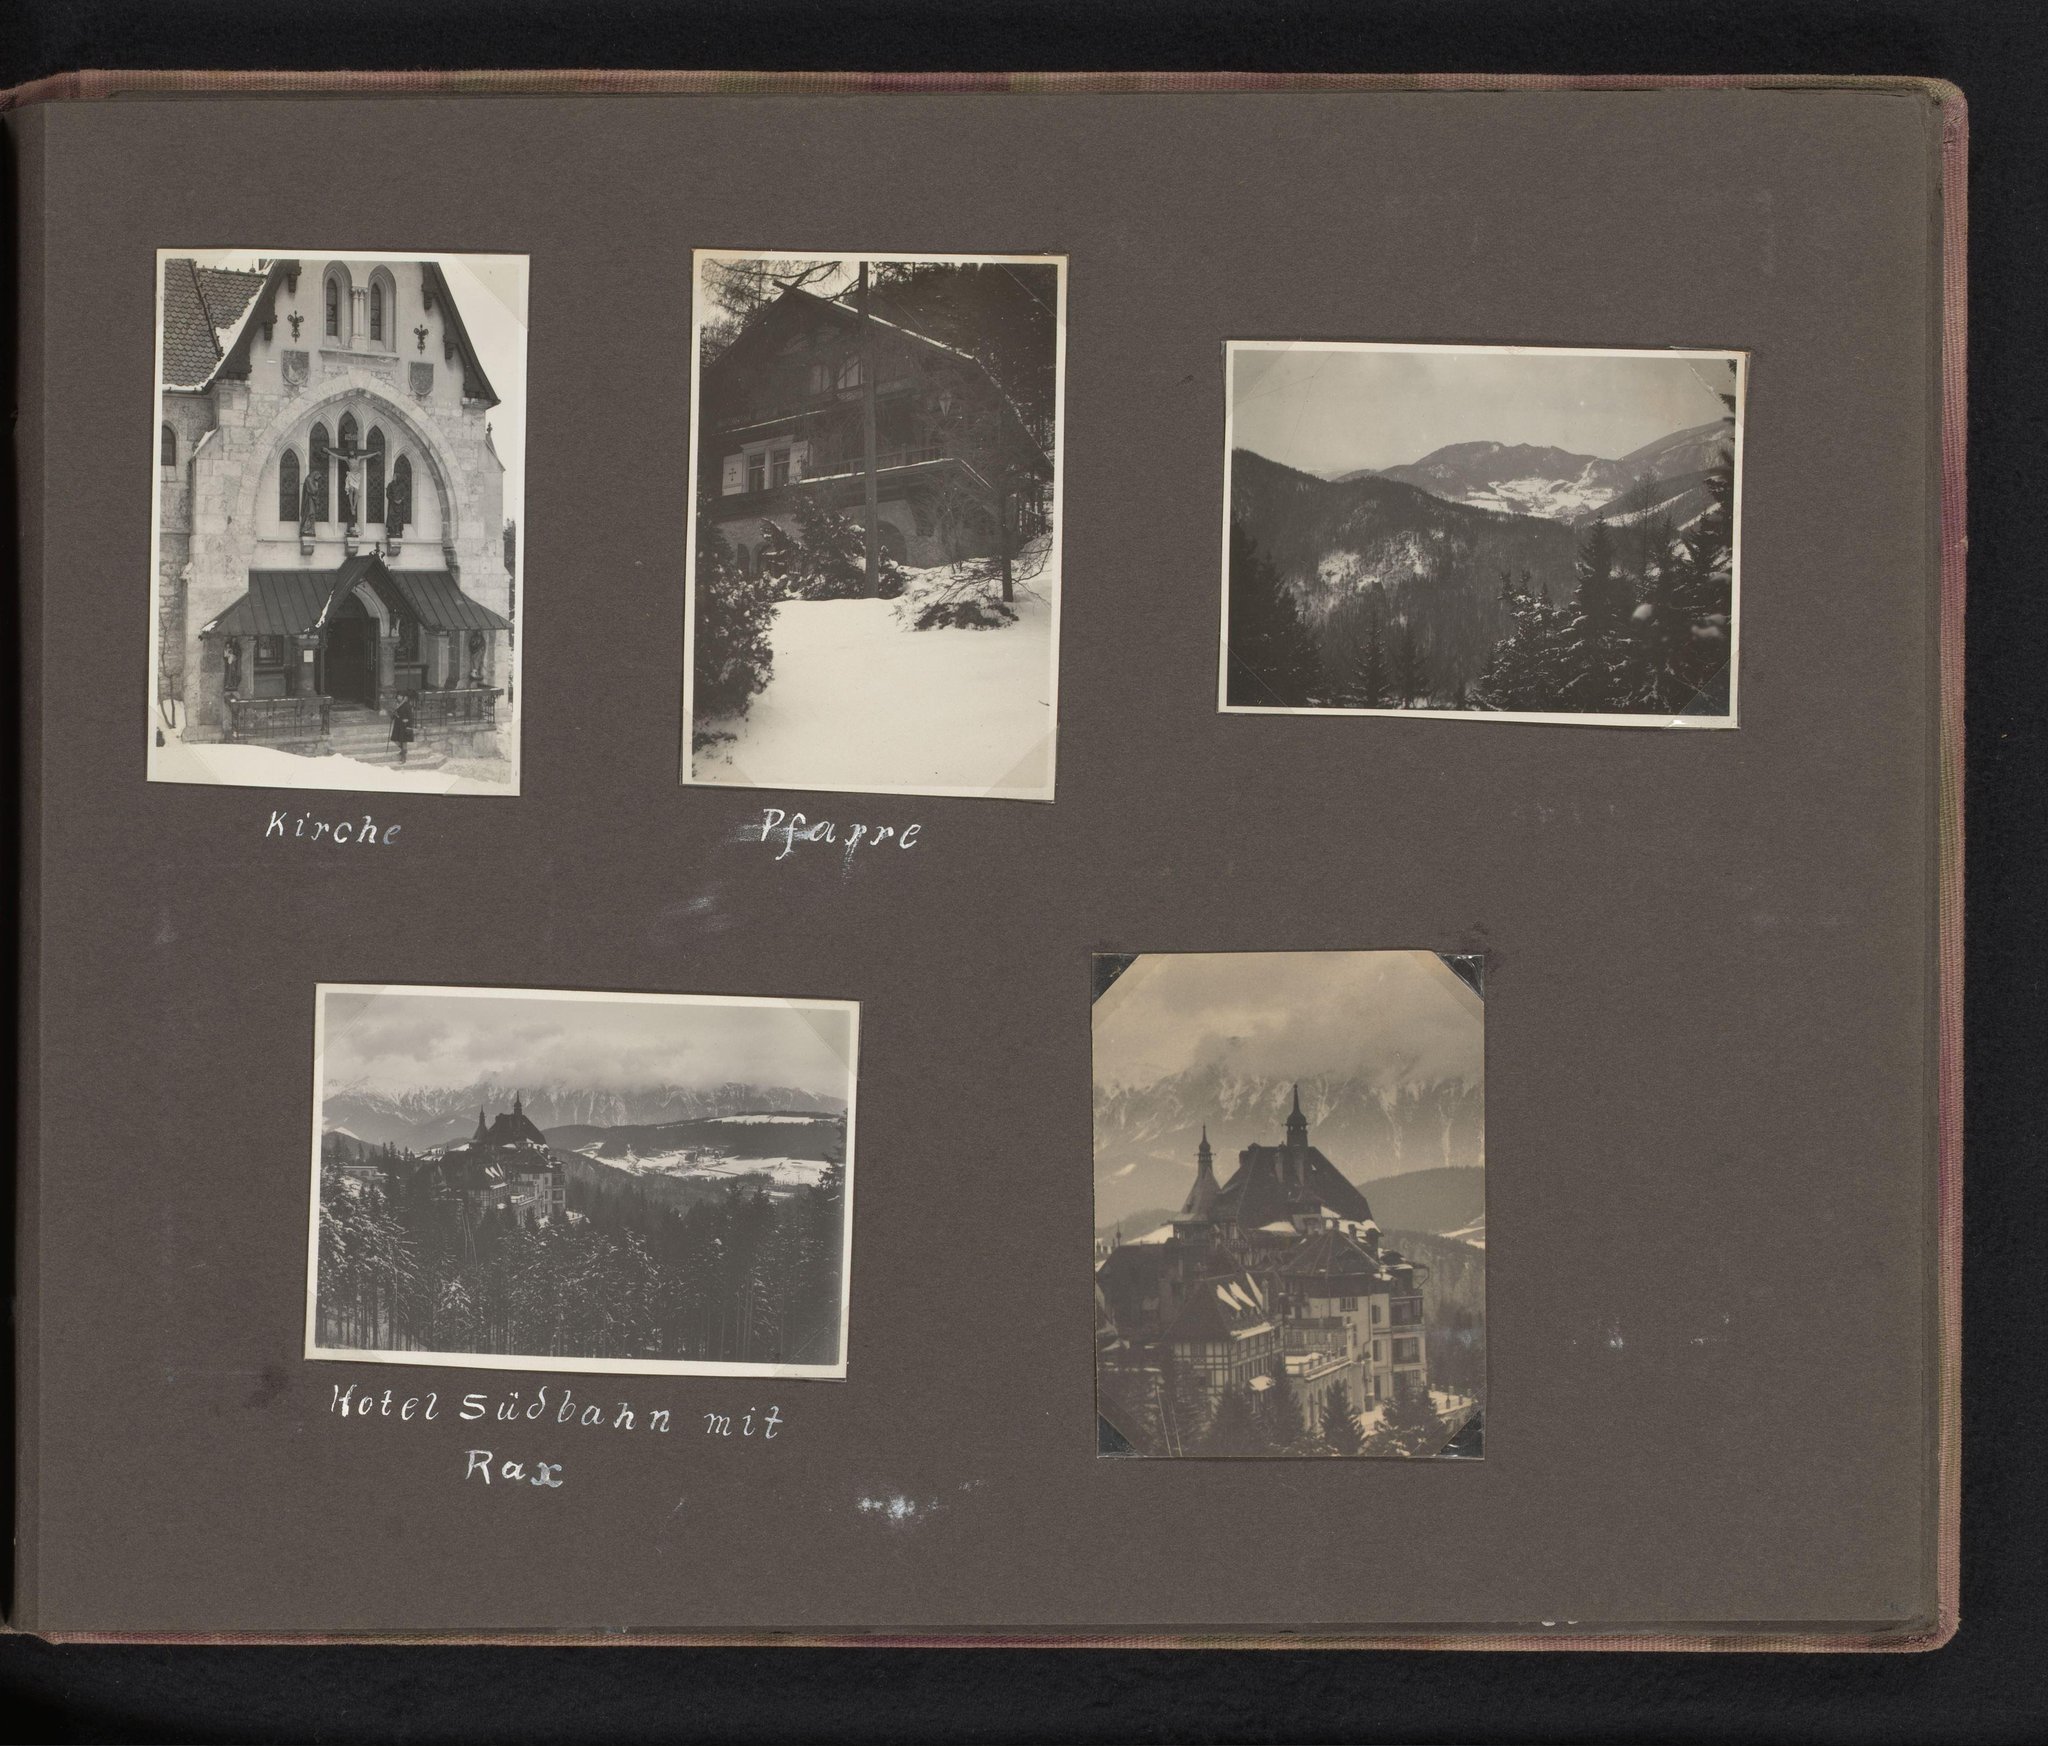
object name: album leaf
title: Wintersportvakantie in Semmering, Oostenrijk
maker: berti hoppe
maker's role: fotograaf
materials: cardboard, photographic support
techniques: gelatin silver print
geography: semmering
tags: church (exterior), winter landscape; landscape symbolizing winter (the four seasons of the year), hotel, hostelry, inn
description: Vier gezichten op gebouwen en een winterlandschap in Semmering. In de onderschriften is vermeld dat het gaat om een kerk, een parochiegebouw en twee gezichten op het Südbahnhotel. Deze foto's maken deel uit van een album.